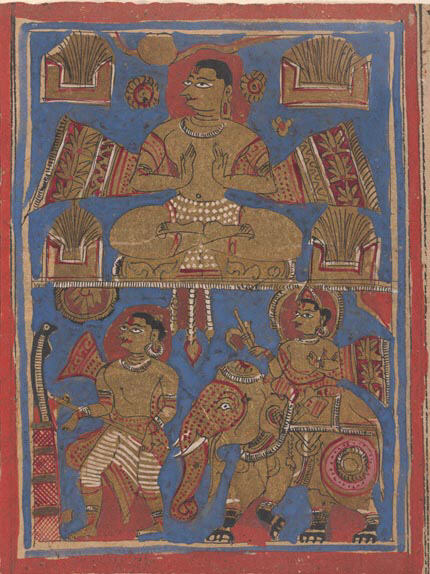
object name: folio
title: Kamatha Performing the Five Fire Penances (top) and Parsvanatha Rescuing the Snake Dharana (bottom): Folio from a Kalpasutra Manuscript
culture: indian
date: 1401-1500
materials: gold, ink, paper, watercolor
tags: elephants,gods